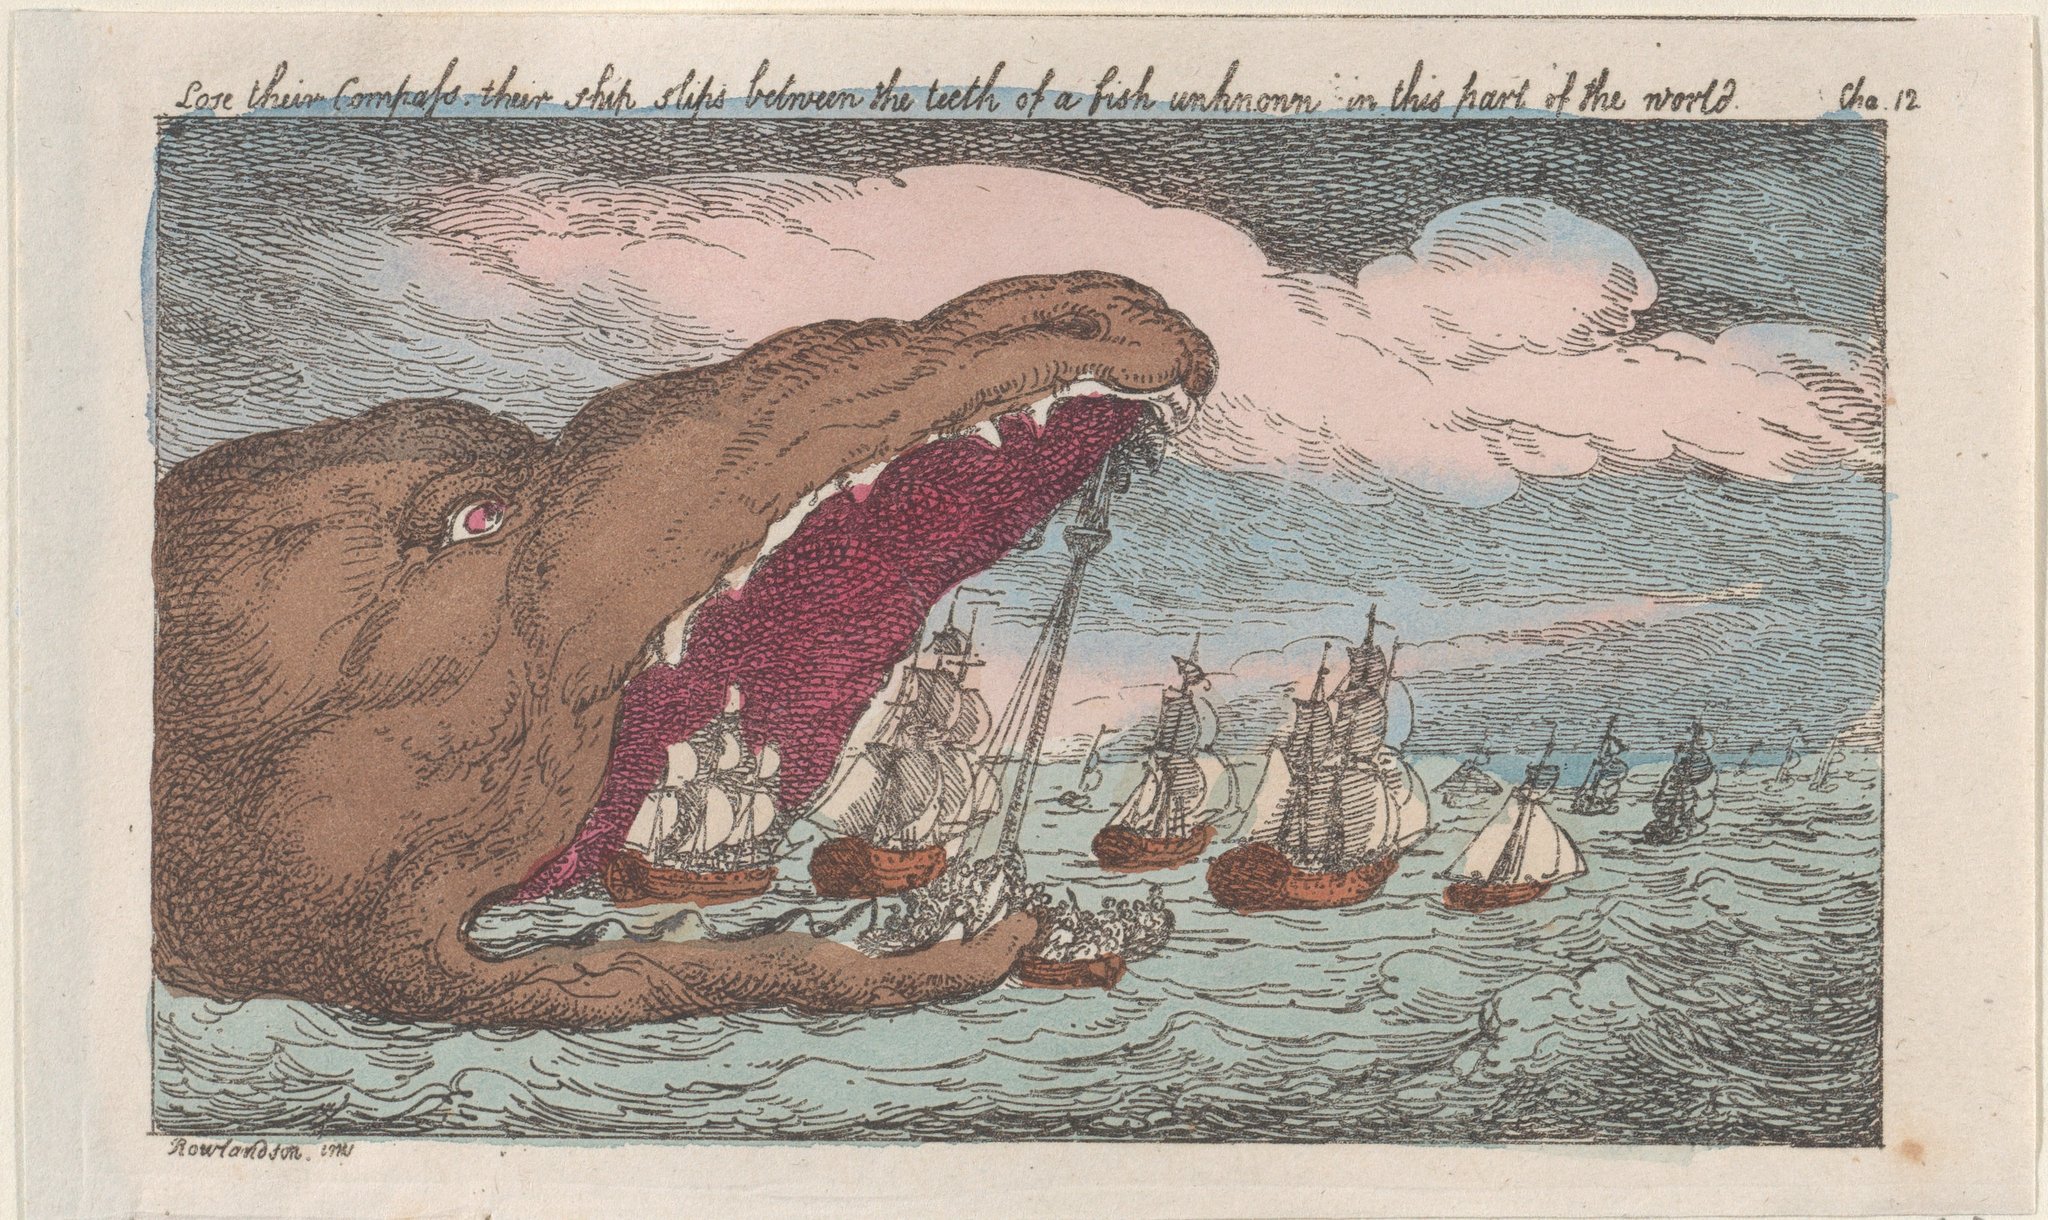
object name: print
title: Lose their Compass, their ships slips between the teeth of a fish unknown in this part of the world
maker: thomas rowlandson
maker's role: artist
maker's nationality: british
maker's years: 1757-1827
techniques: etching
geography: london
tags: satire,fish,ships